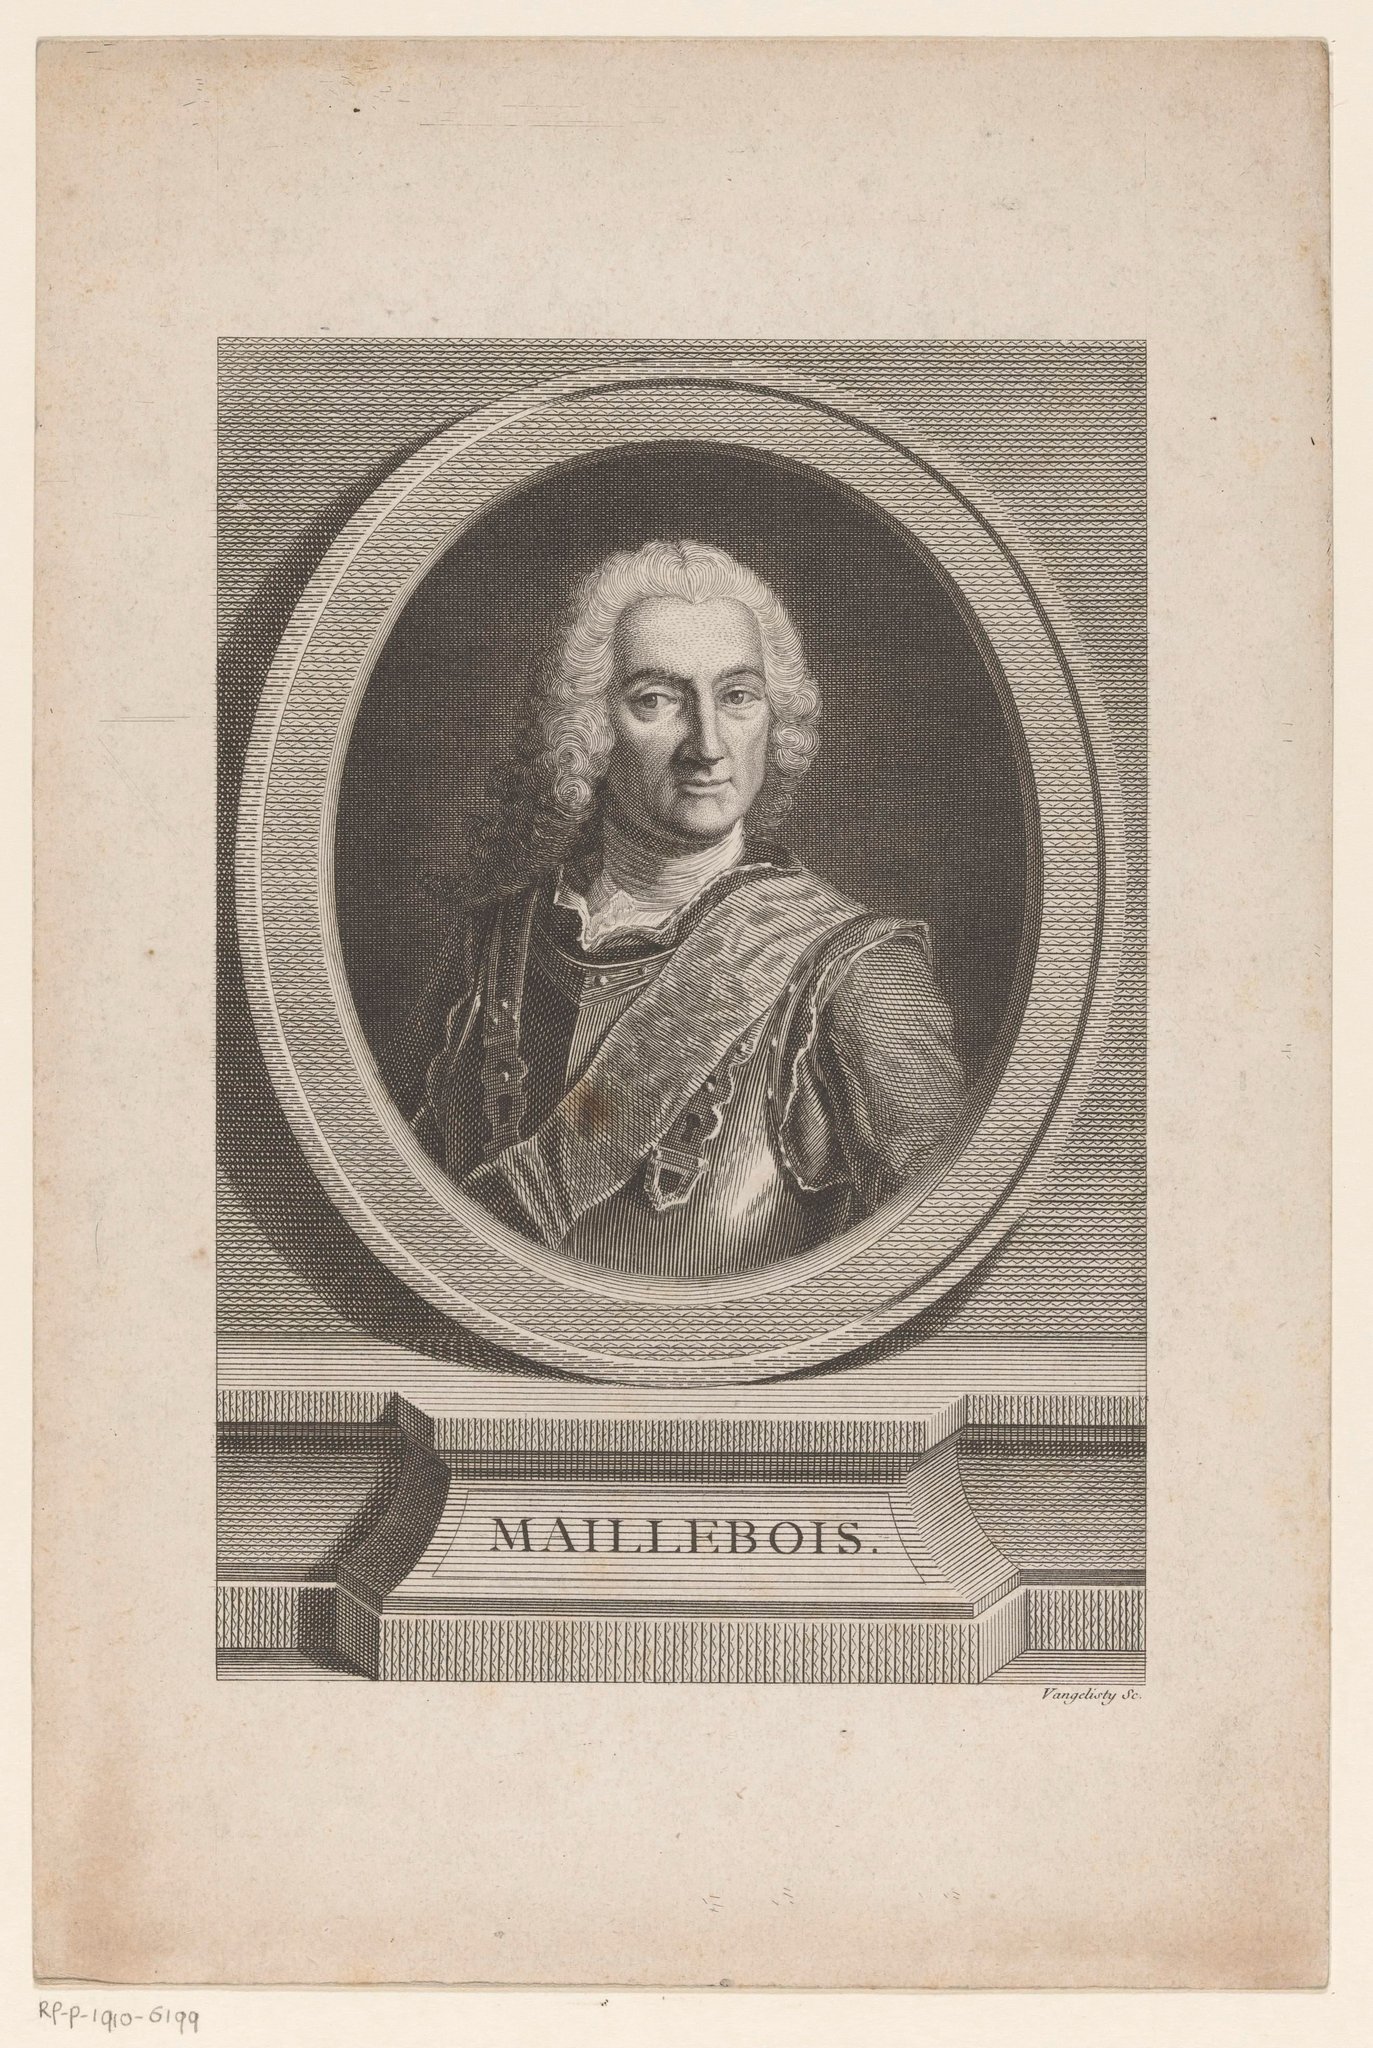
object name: print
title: Portretten van Franse leiders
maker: vincenzo vangelisti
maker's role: print maker, publisher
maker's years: 1728-1798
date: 1738-1798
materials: paper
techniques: engraving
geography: paris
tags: paris, historical persons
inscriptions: collector's mark: Lugt 2228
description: Prent gebruikt voor de publicatie: Turpin, François-Henri en Vincenzo Vangelisti. La France Illustre ou Le Plutarque Français. Parijs: s.n., 1775-1790.